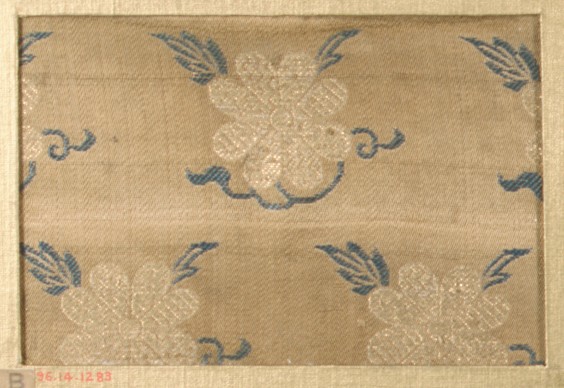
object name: piece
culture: japanese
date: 1701-1900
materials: silk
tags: flowers